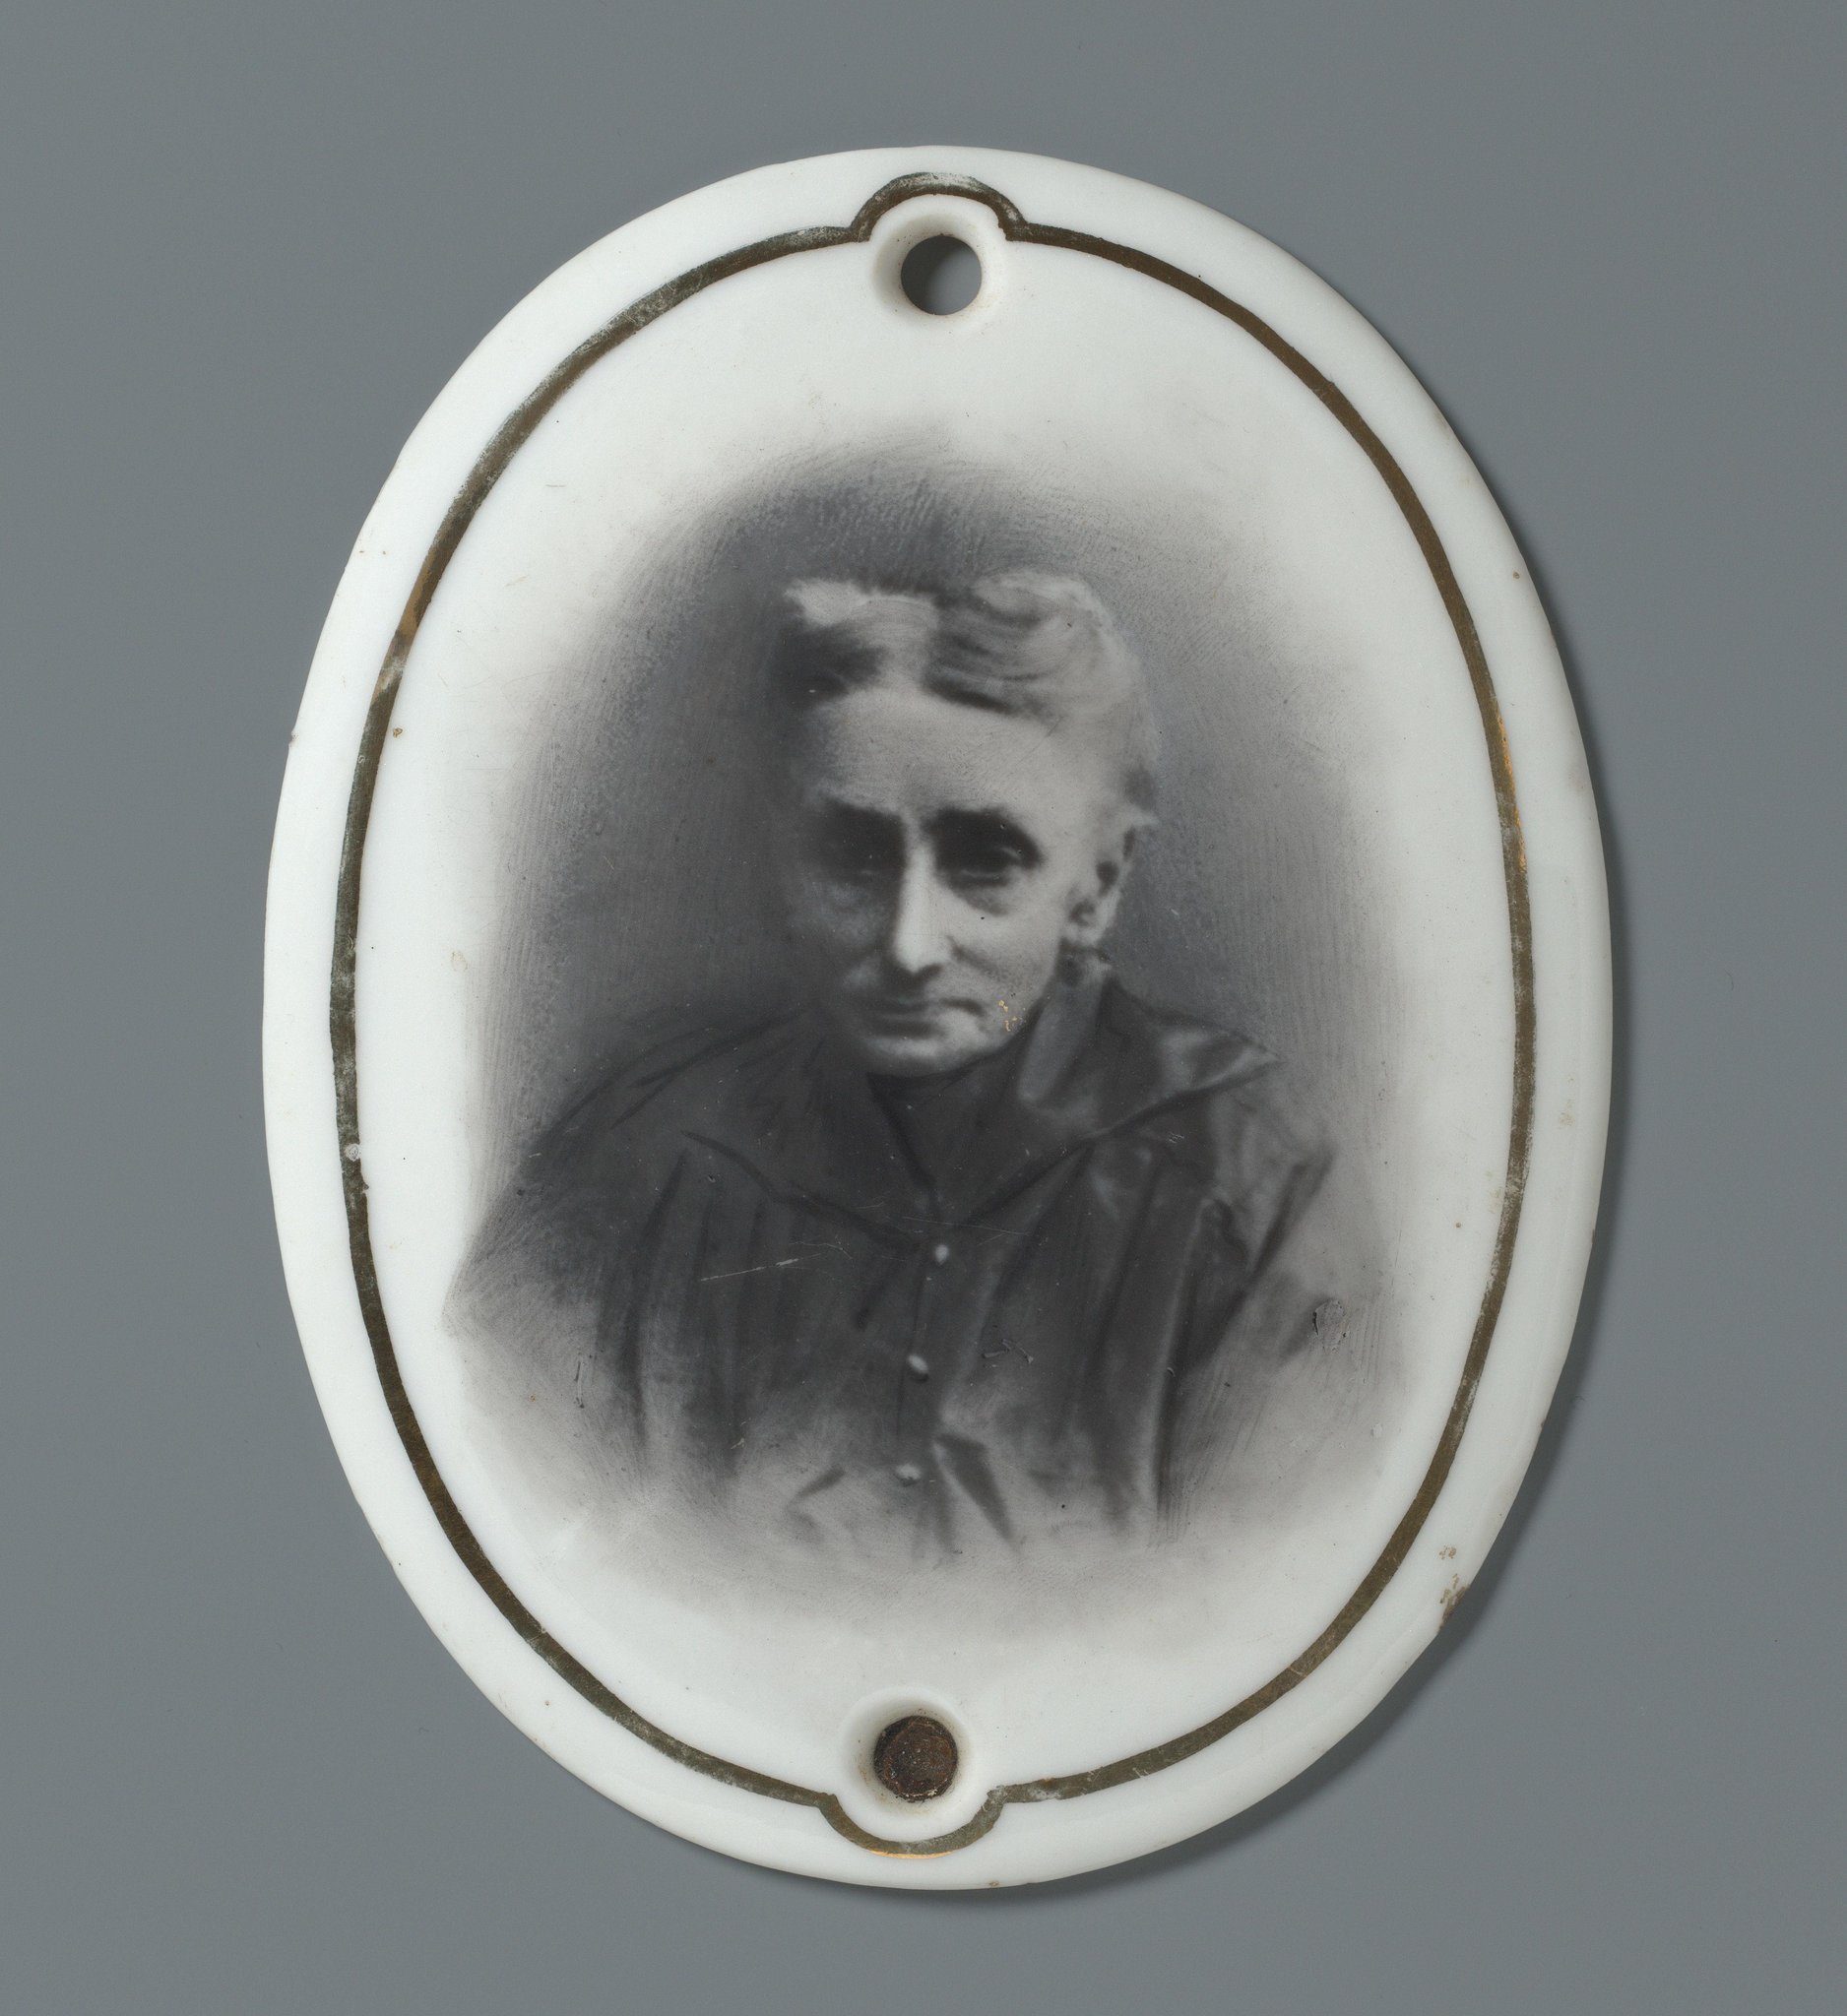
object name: photograph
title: Portret van een onbekende oude vrouw op keramieken ovale plaquette van een graf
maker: Anonymous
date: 1890-1920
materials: ceramic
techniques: gelatin silver print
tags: historical persons not known by name - bb - woman, old woman